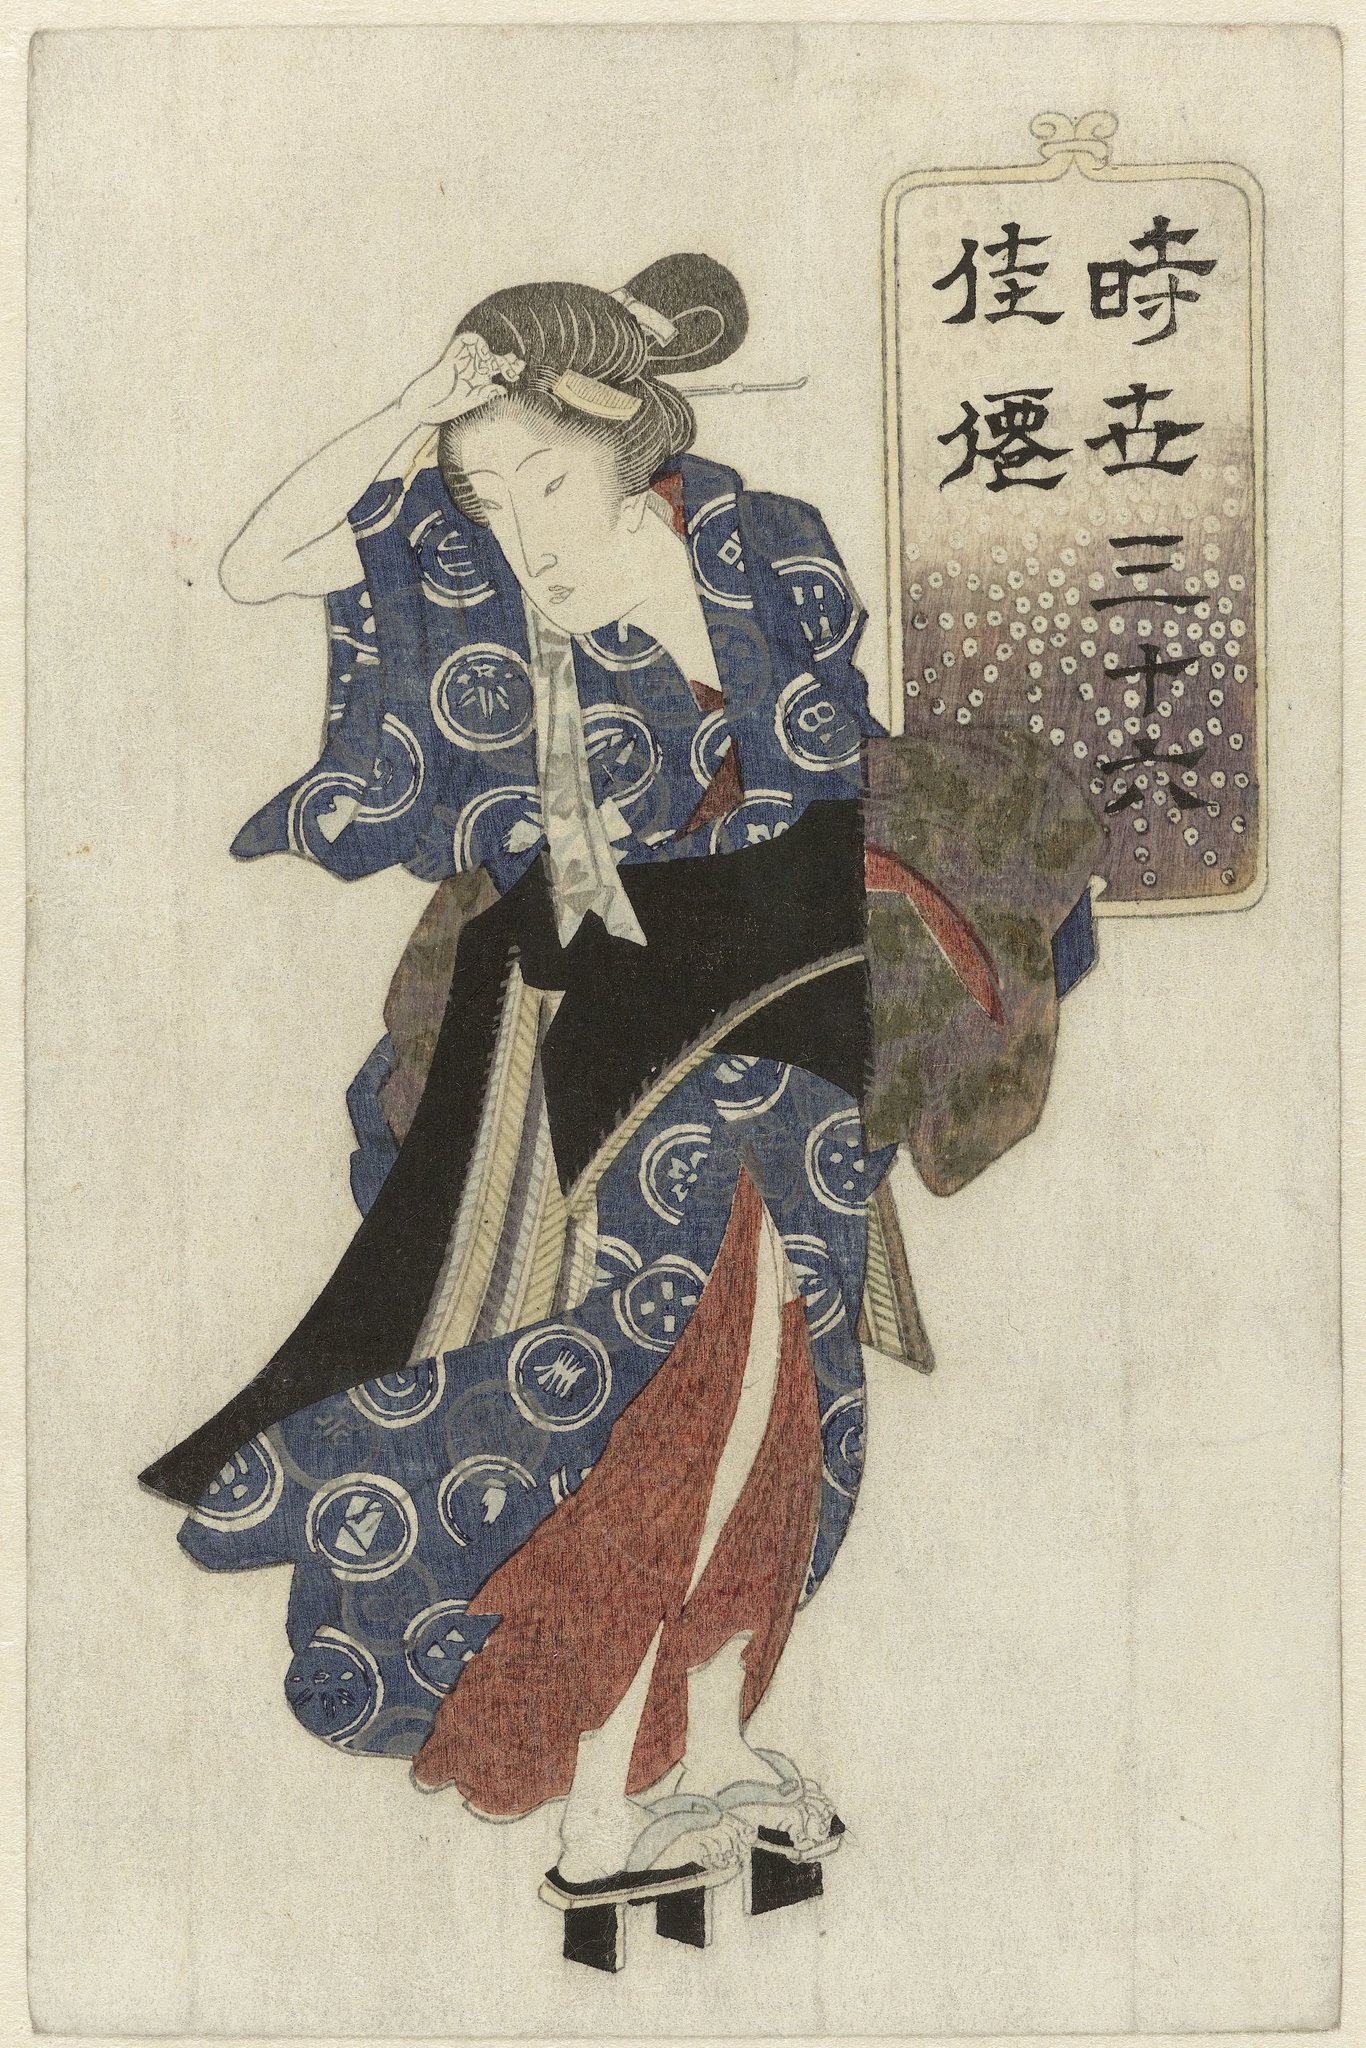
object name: print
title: Staande vrouw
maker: Anonymous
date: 1825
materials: paper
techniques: woodcut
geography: japan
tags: 'après le bain'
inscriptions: collector's mark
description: Een vrouw heeft zojuist het badhuis verlaten.